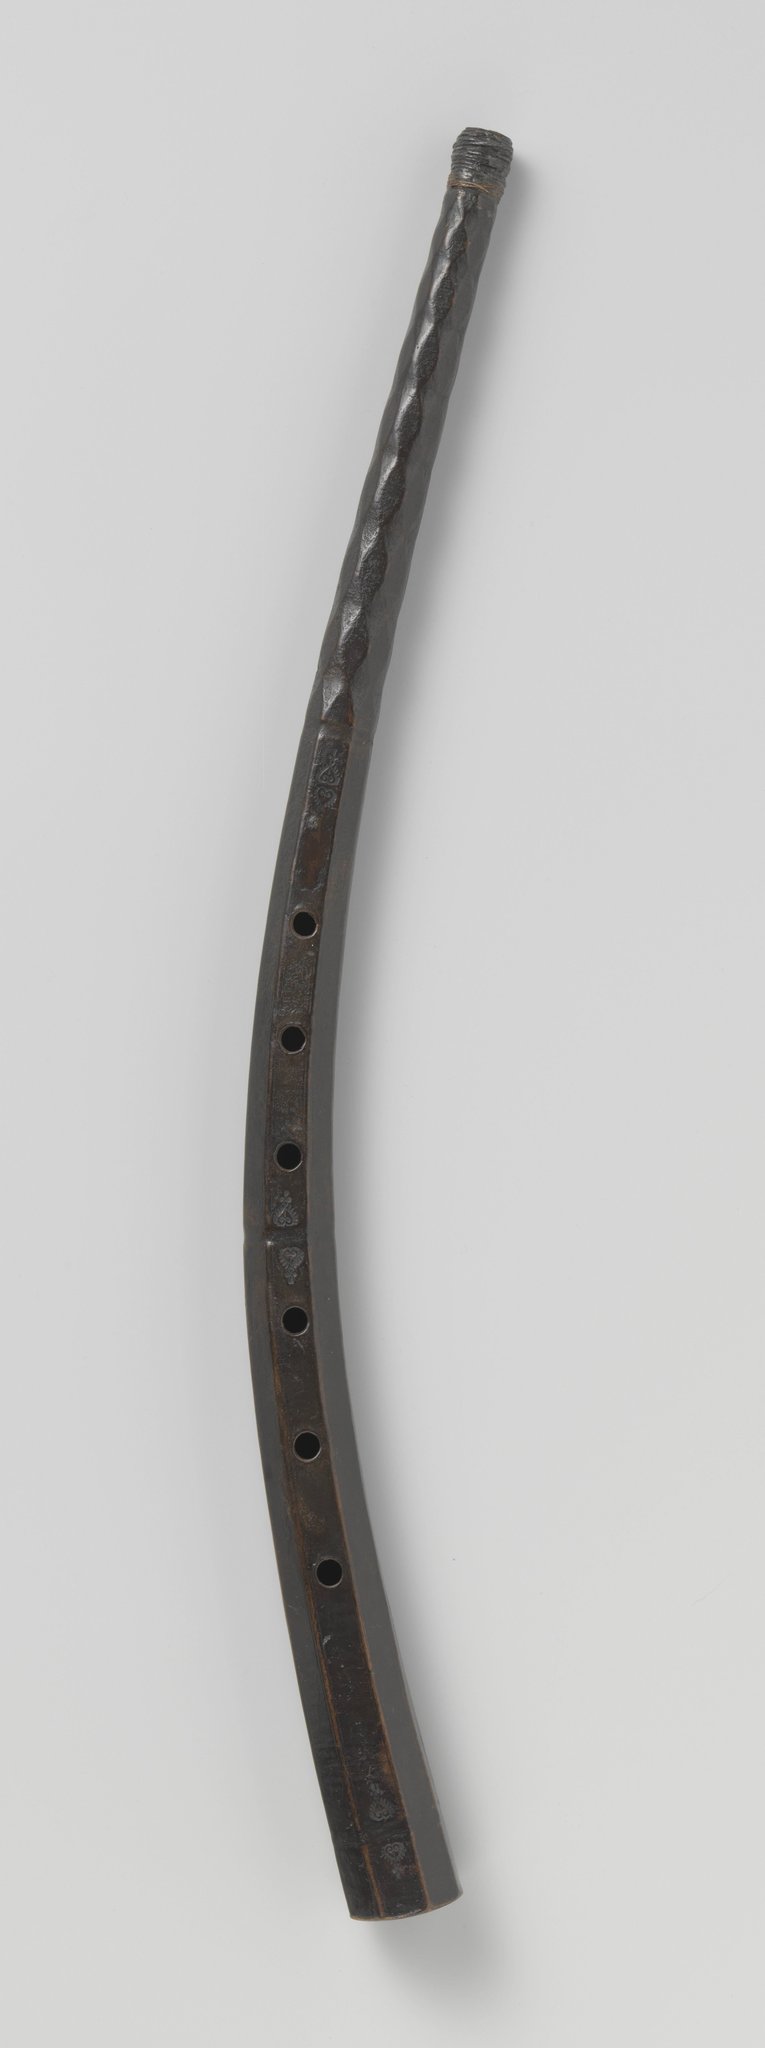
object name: cornett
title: Cornetto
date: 1600-1650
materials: leather, wood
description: The cornetto is usually made of two glued wooden halves covered in leather. Similarly to the trumpet, it is played using a mouthpiece. Its sweet sound resembles the human voice. Between 1550 and 1650, the cornetto was so popular that its best players, famous violin virtuosos and celebrated singers were equally acclaimed.